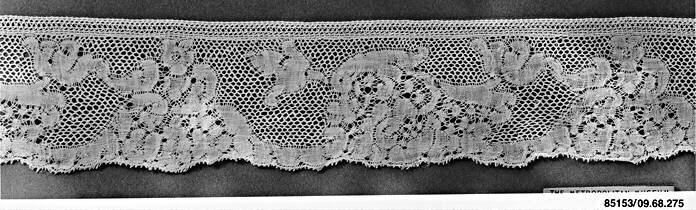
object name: border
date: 1701-1800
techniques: lace